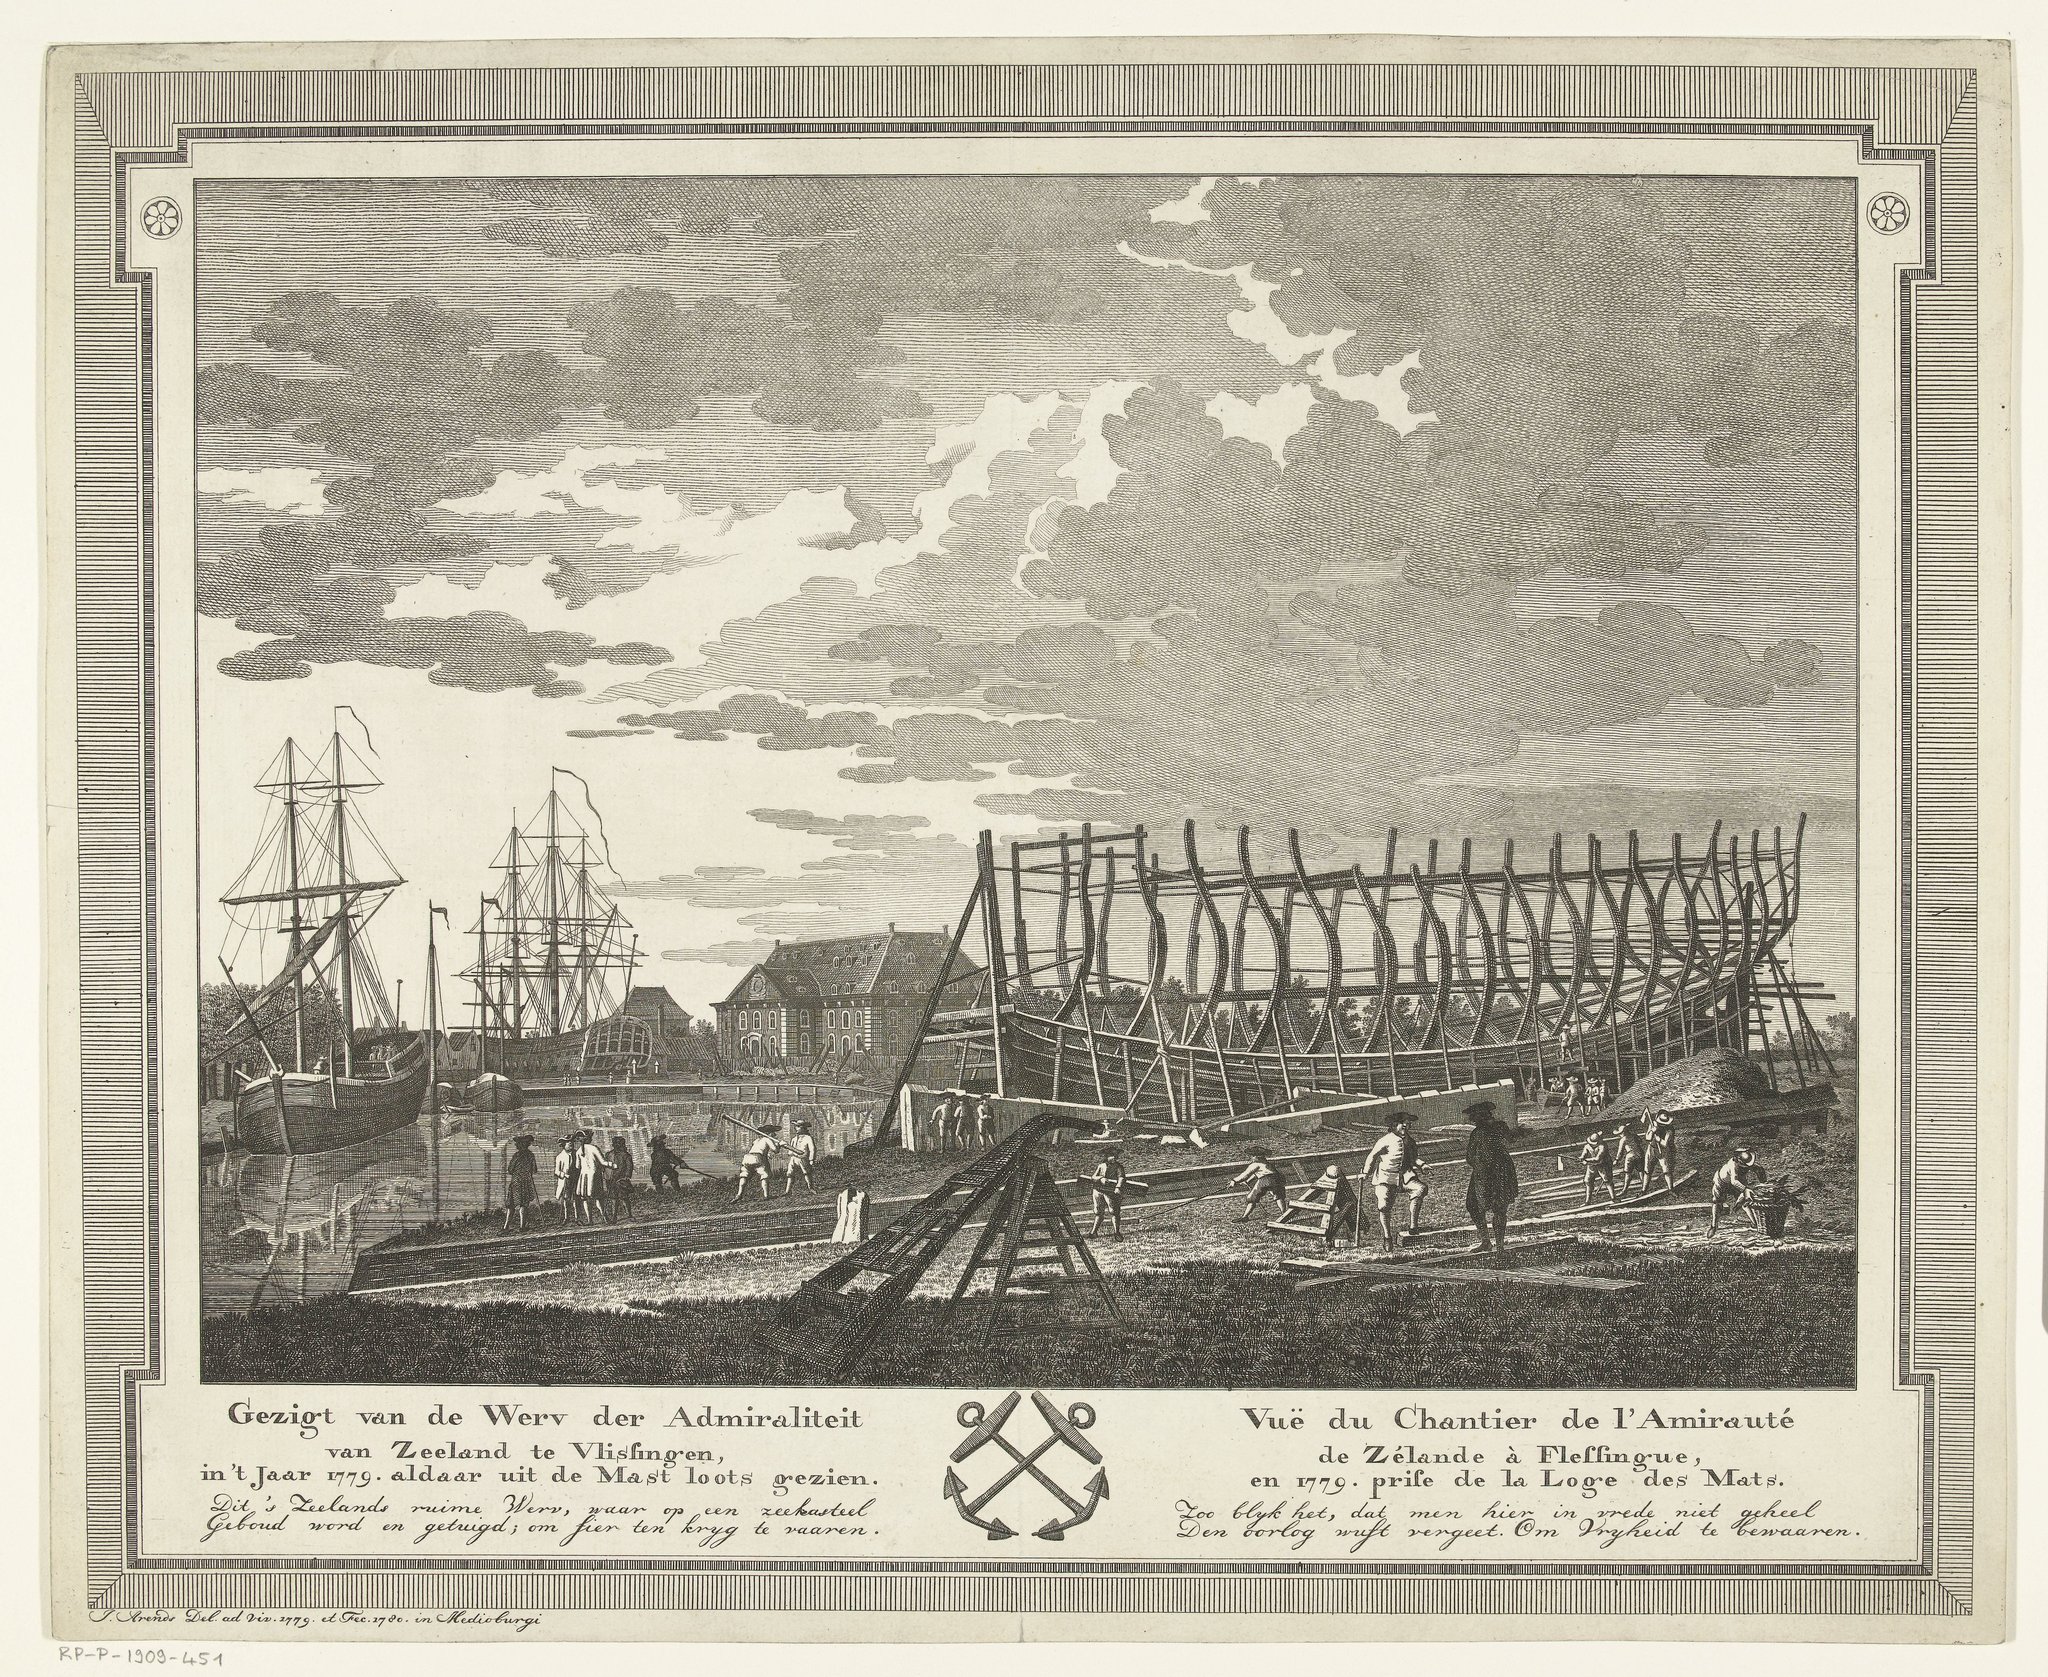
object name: print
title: Gezicht op de Admiraliteitswerf te Vlissingen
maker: jan arends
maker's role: draughtsman, print maker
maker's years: 1738-1805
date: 1779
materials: paper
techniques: etching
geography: middelburg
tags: pier, quay, wharf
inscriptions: collector's mark: Lugt 2228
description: Gezicht op de Admiraliteitswerf te Vlissingen gezien vanuit een scheepsmast. Met verklarend onderschrift in het Frans en het Nederlands, en een vers van vier regels in het Nederlands.